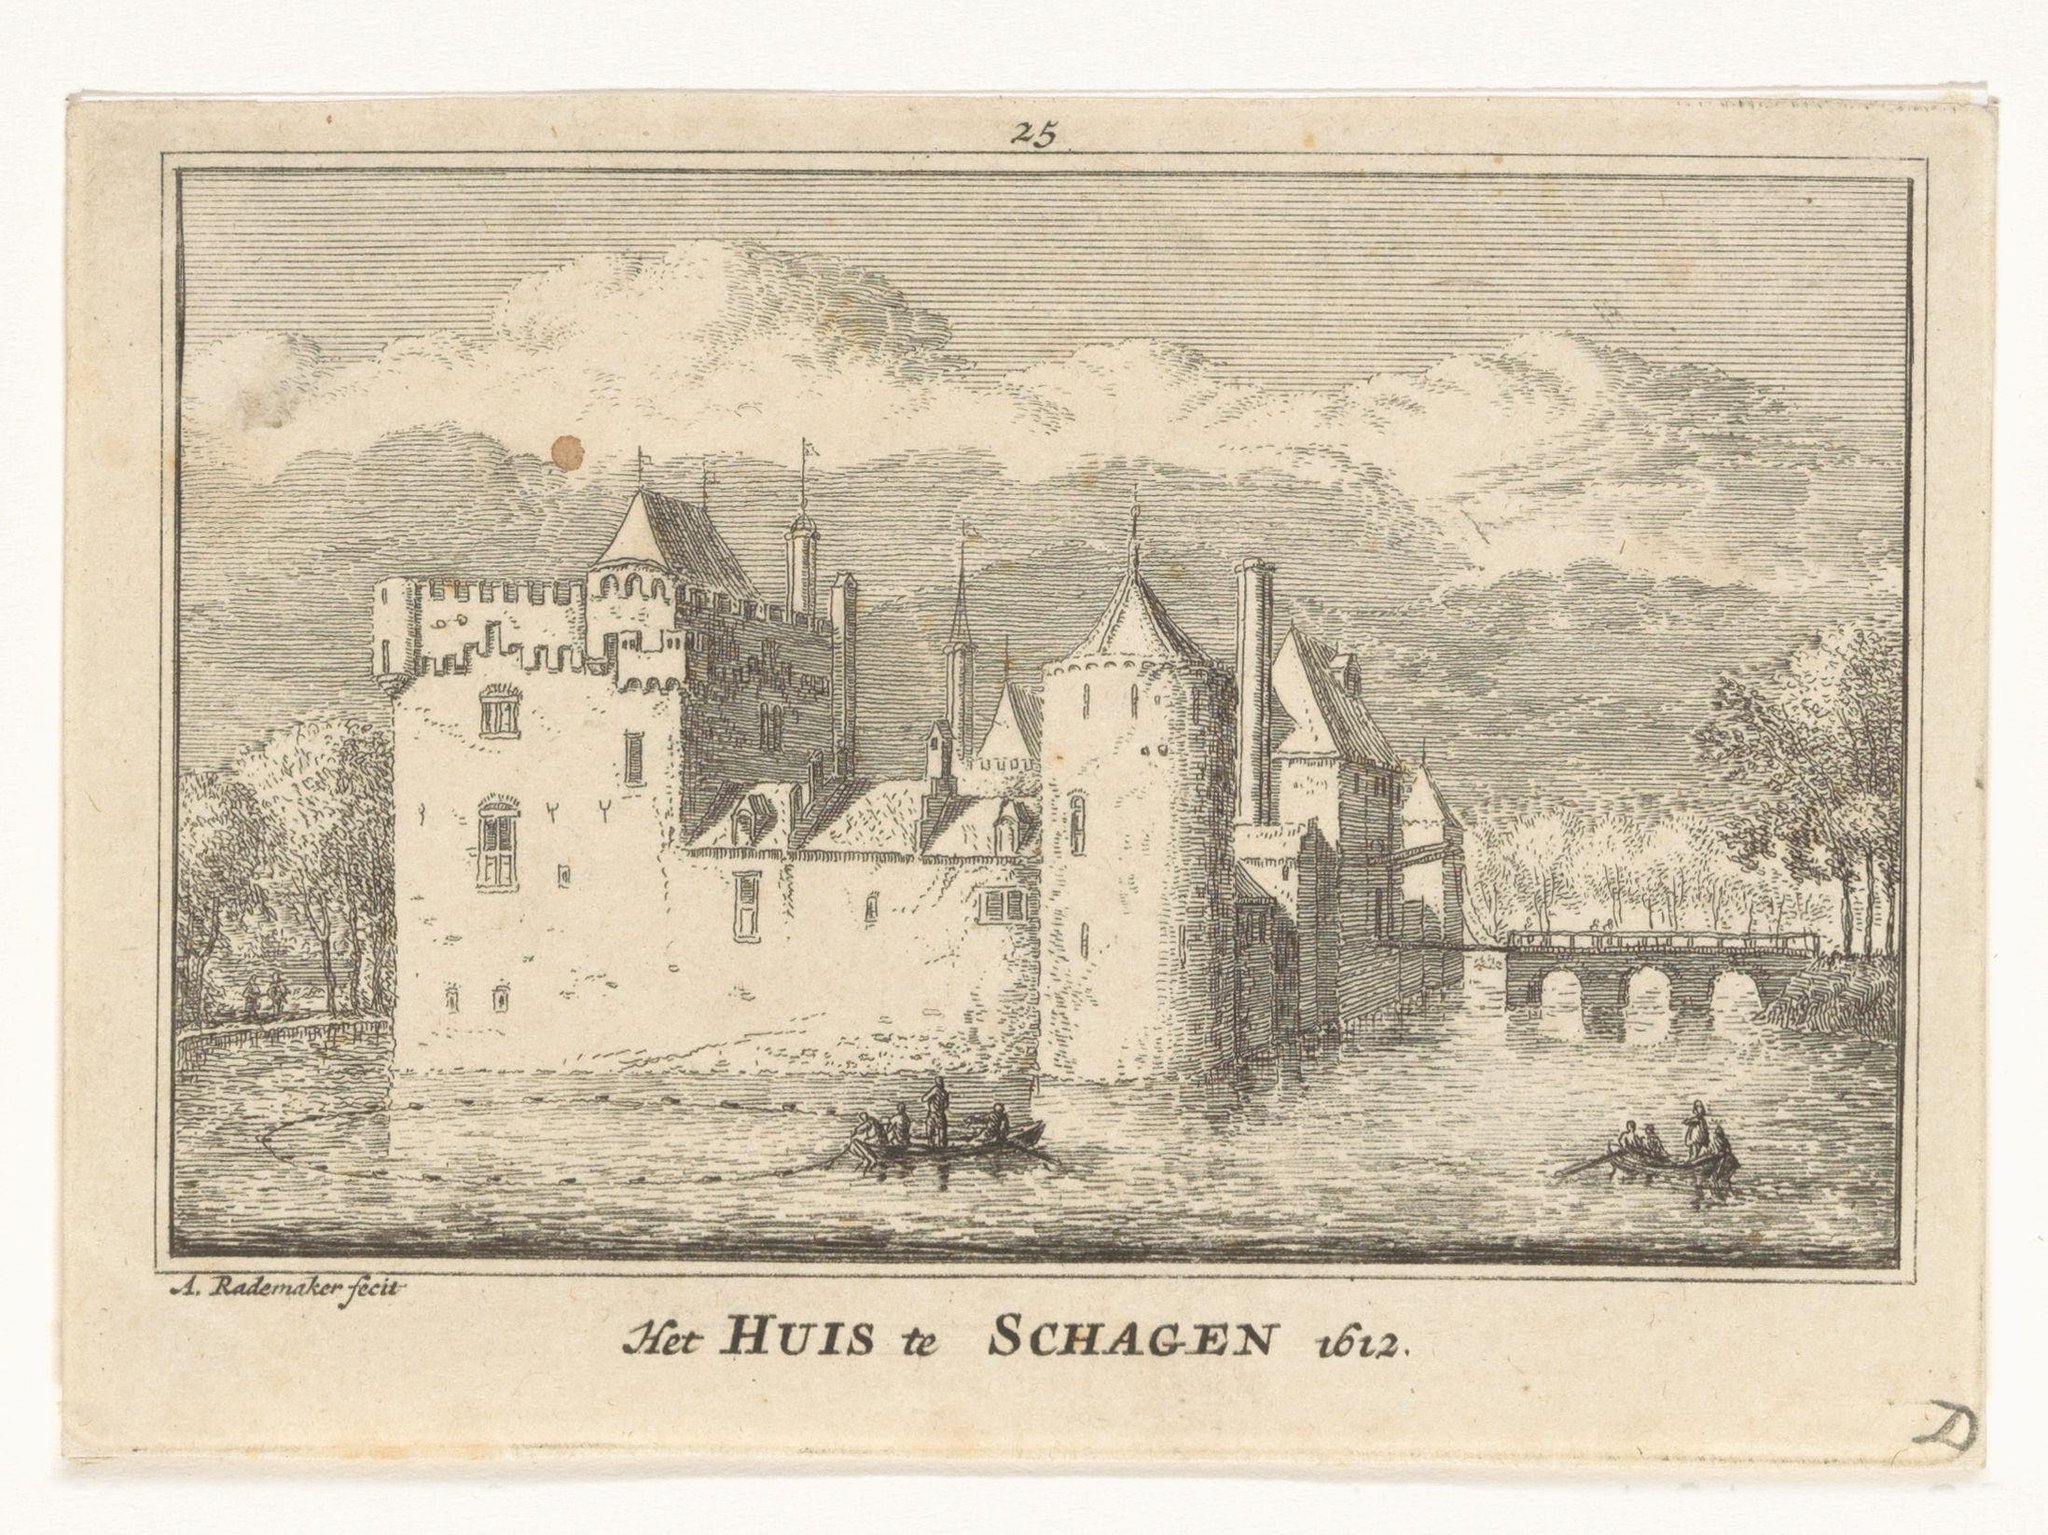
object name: book illustration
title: Gezicht op Huis te Schagen, 1612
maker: abraham rademaker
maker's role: draughtsman, print maker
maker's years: 1676-1735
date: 1725-1803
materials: paper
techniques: engraving, etching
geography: amsterdam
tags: castle, rowing-boat, canoe, etc., fisherman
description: Prent ook gebruikt in: Rademaker, Abraham. Kabinet van Nederlandsche outheden en gezichten: vervat in 300 konstplaaten (…). 2 delen. Amsterdam: Willem Barents, 1725, dl. 1, ill. 25. Na 1725 is deze prent nog in verschillende heruitgaven verschenen, uitgegeven in 1727-1733, 1770-1771 en 1792-1803. Uit welke uitgave het huidige exemplaar precies komt is niet na te gaan.